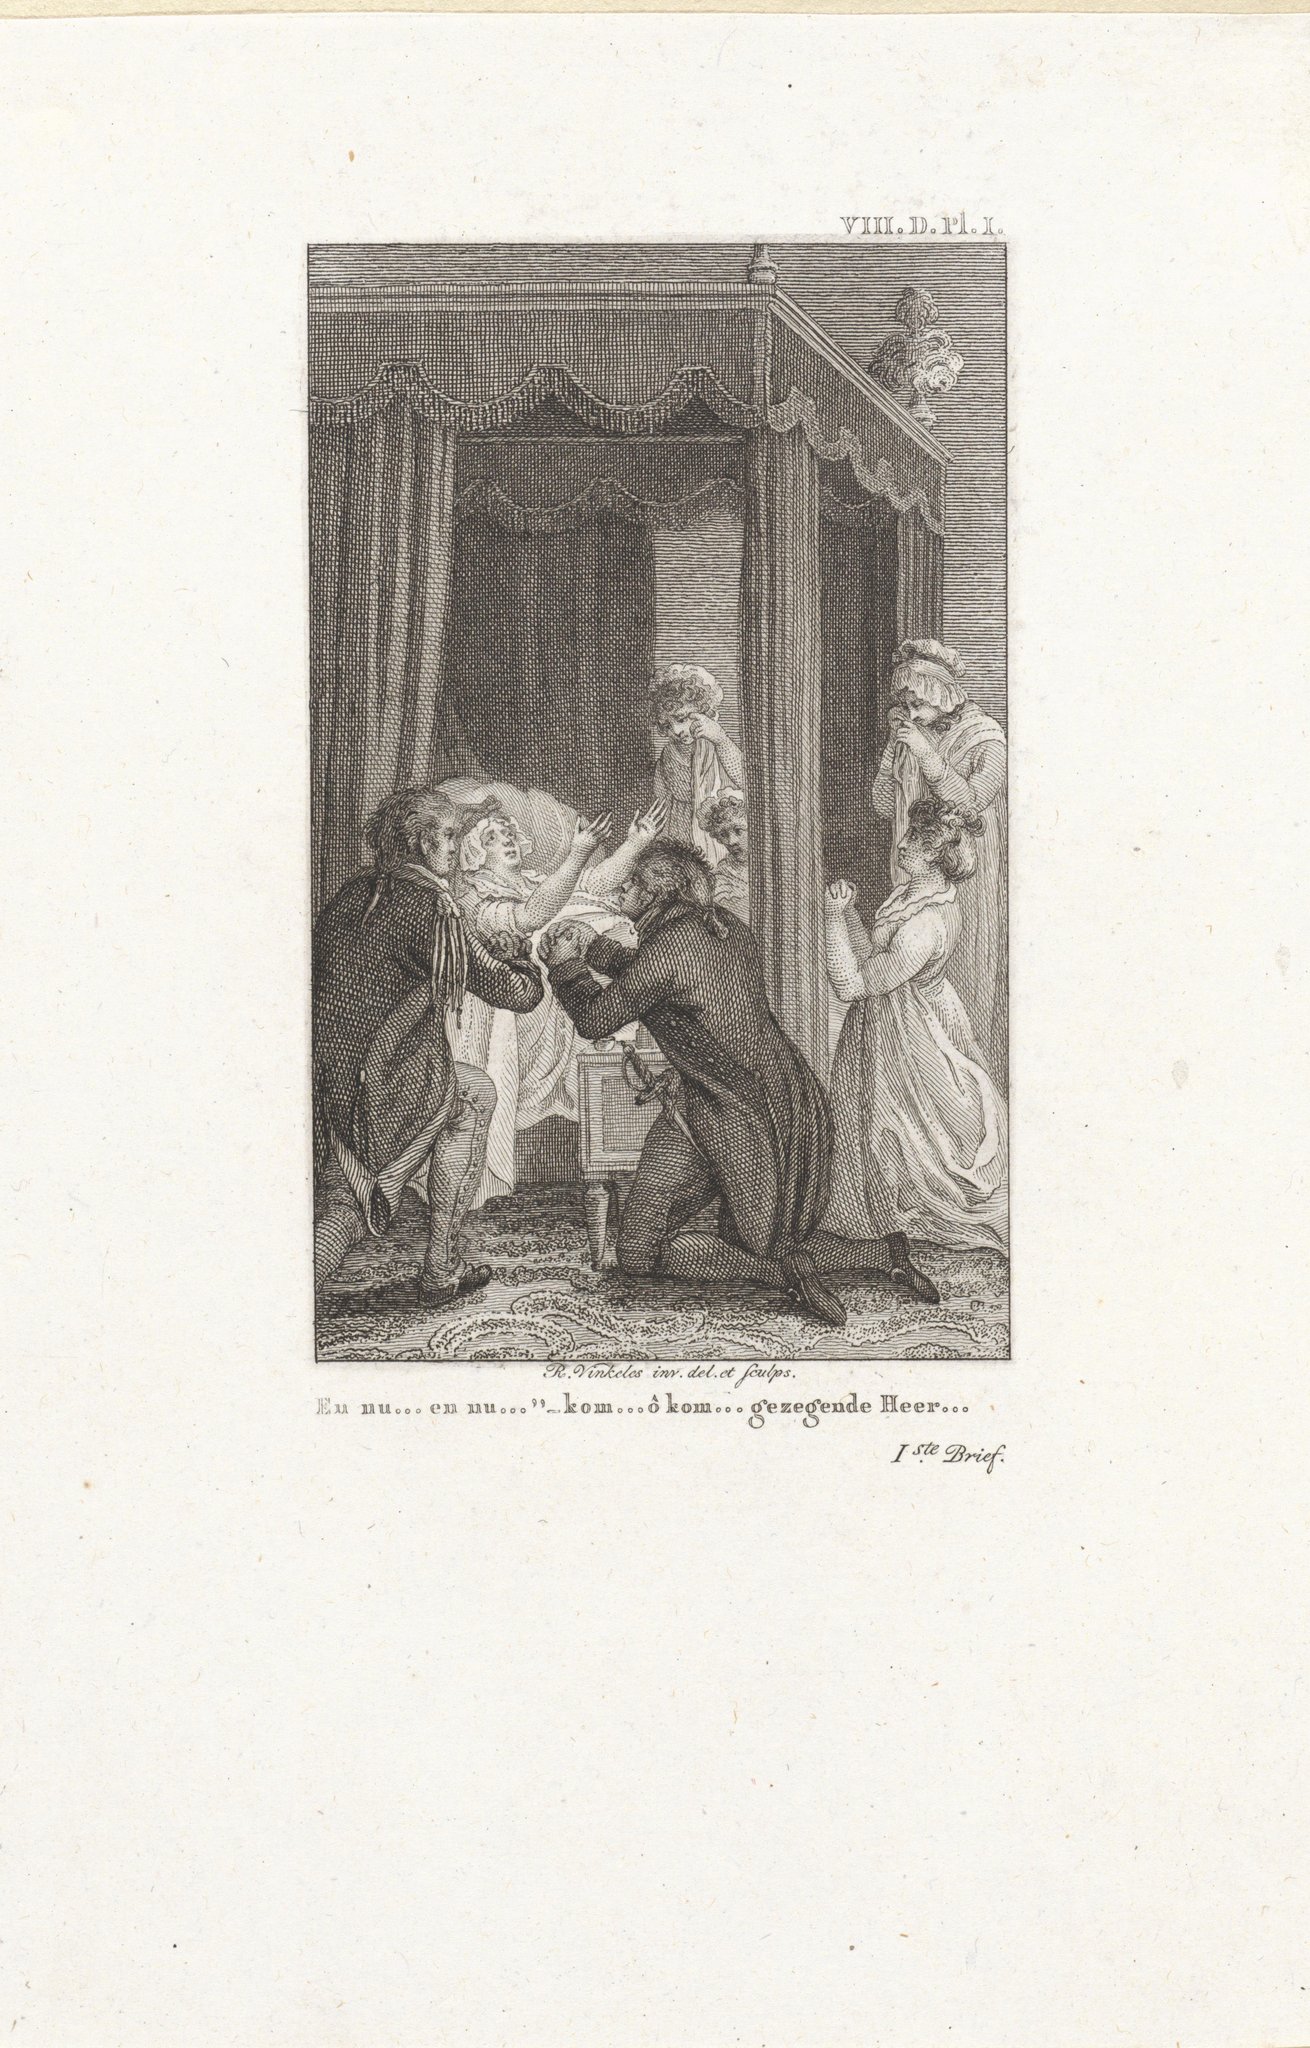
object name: print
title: Biddende en huilende figuren bij het ziekbed van Clarissa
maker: reinier vinkeles (i)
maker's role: draughtsman, print maker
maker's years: 1741-1816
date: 1805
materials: paper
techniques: engraving, etching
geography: amsterdam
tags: weeping, kneeling figure, visiting the sick; sick person together with others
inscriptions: collector's mark: Lugt 240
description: Illustratie uit: Richardson, Samuel. Geschiedenis van Clarissa Harlowe. Deel 8. Amsterdam: Johannes Allart, 1797-1805.